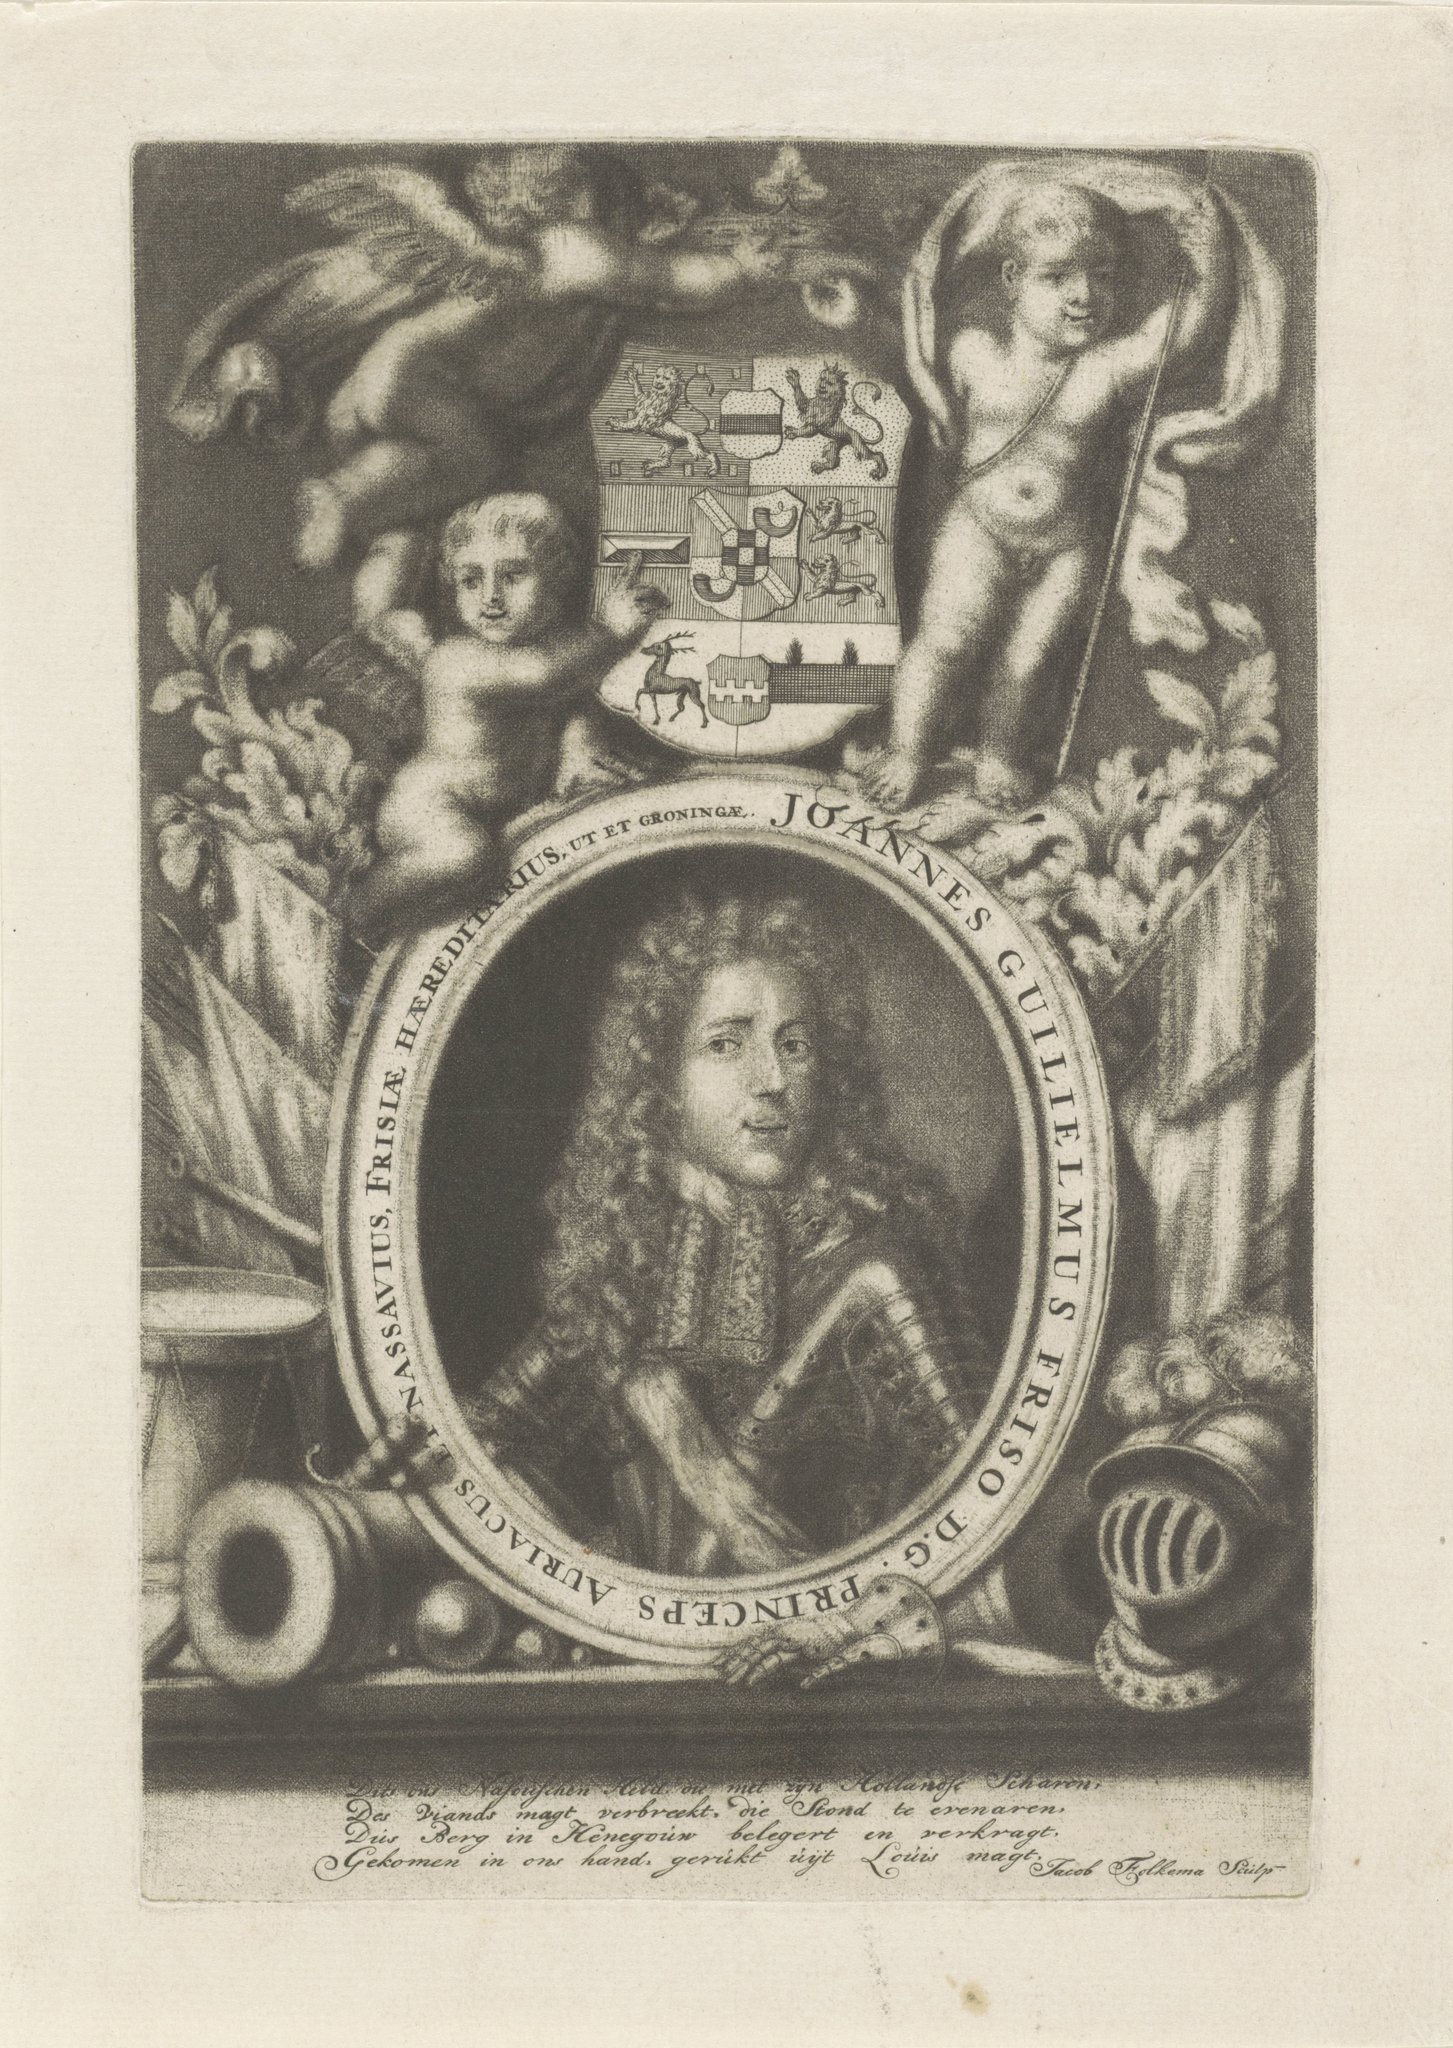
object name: print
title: Portret van Johan Willem Friso, prins van Oranje-Nassau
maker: jacob folkema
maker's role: draughtsman, print maker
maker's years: 1692-1767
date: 1712-1767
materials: paper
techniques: engraving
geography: amsterdam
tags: johan willem friso (prins van oranje-nassau)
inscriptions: collector's mark: Lugt 2228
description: Portret van Johan Willem Friso in een ovaal met randschrift. Daar omheen een aantal allegorische objecten en drie putti. Midden boven zijn wapen. In de ondermarge vier regels Nederlandse tekst.